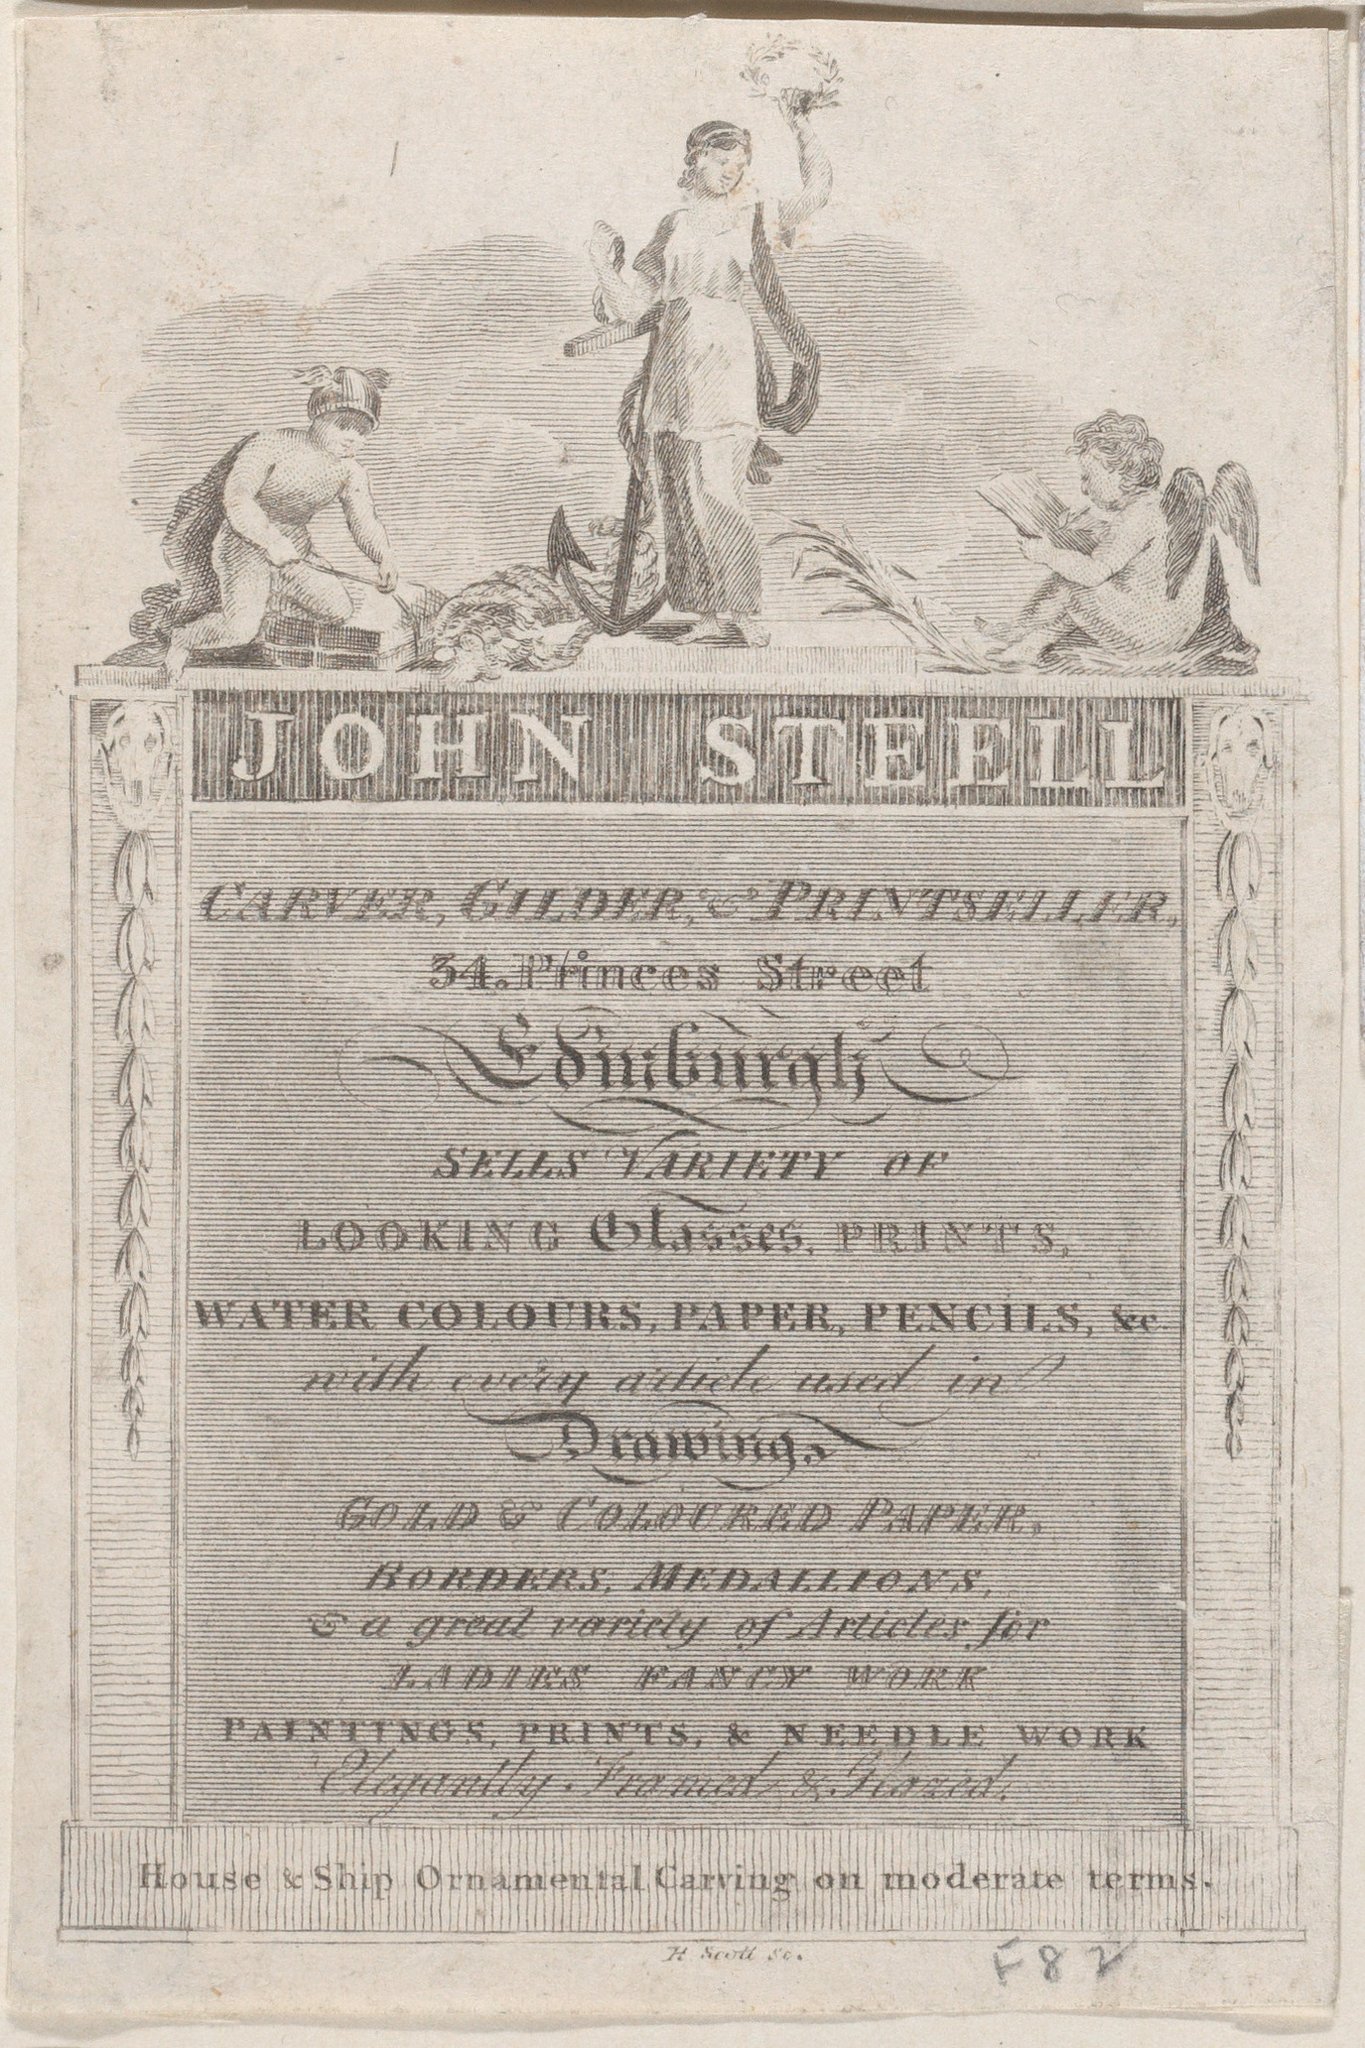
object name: print, trade card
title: Trade Card for John Steell, Carver, Gilder, and Printseller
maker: anonymous, british, late 18th–early 19th century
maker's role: artist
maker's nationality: british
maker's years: 1771-1835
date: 1801-1900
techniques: engraving